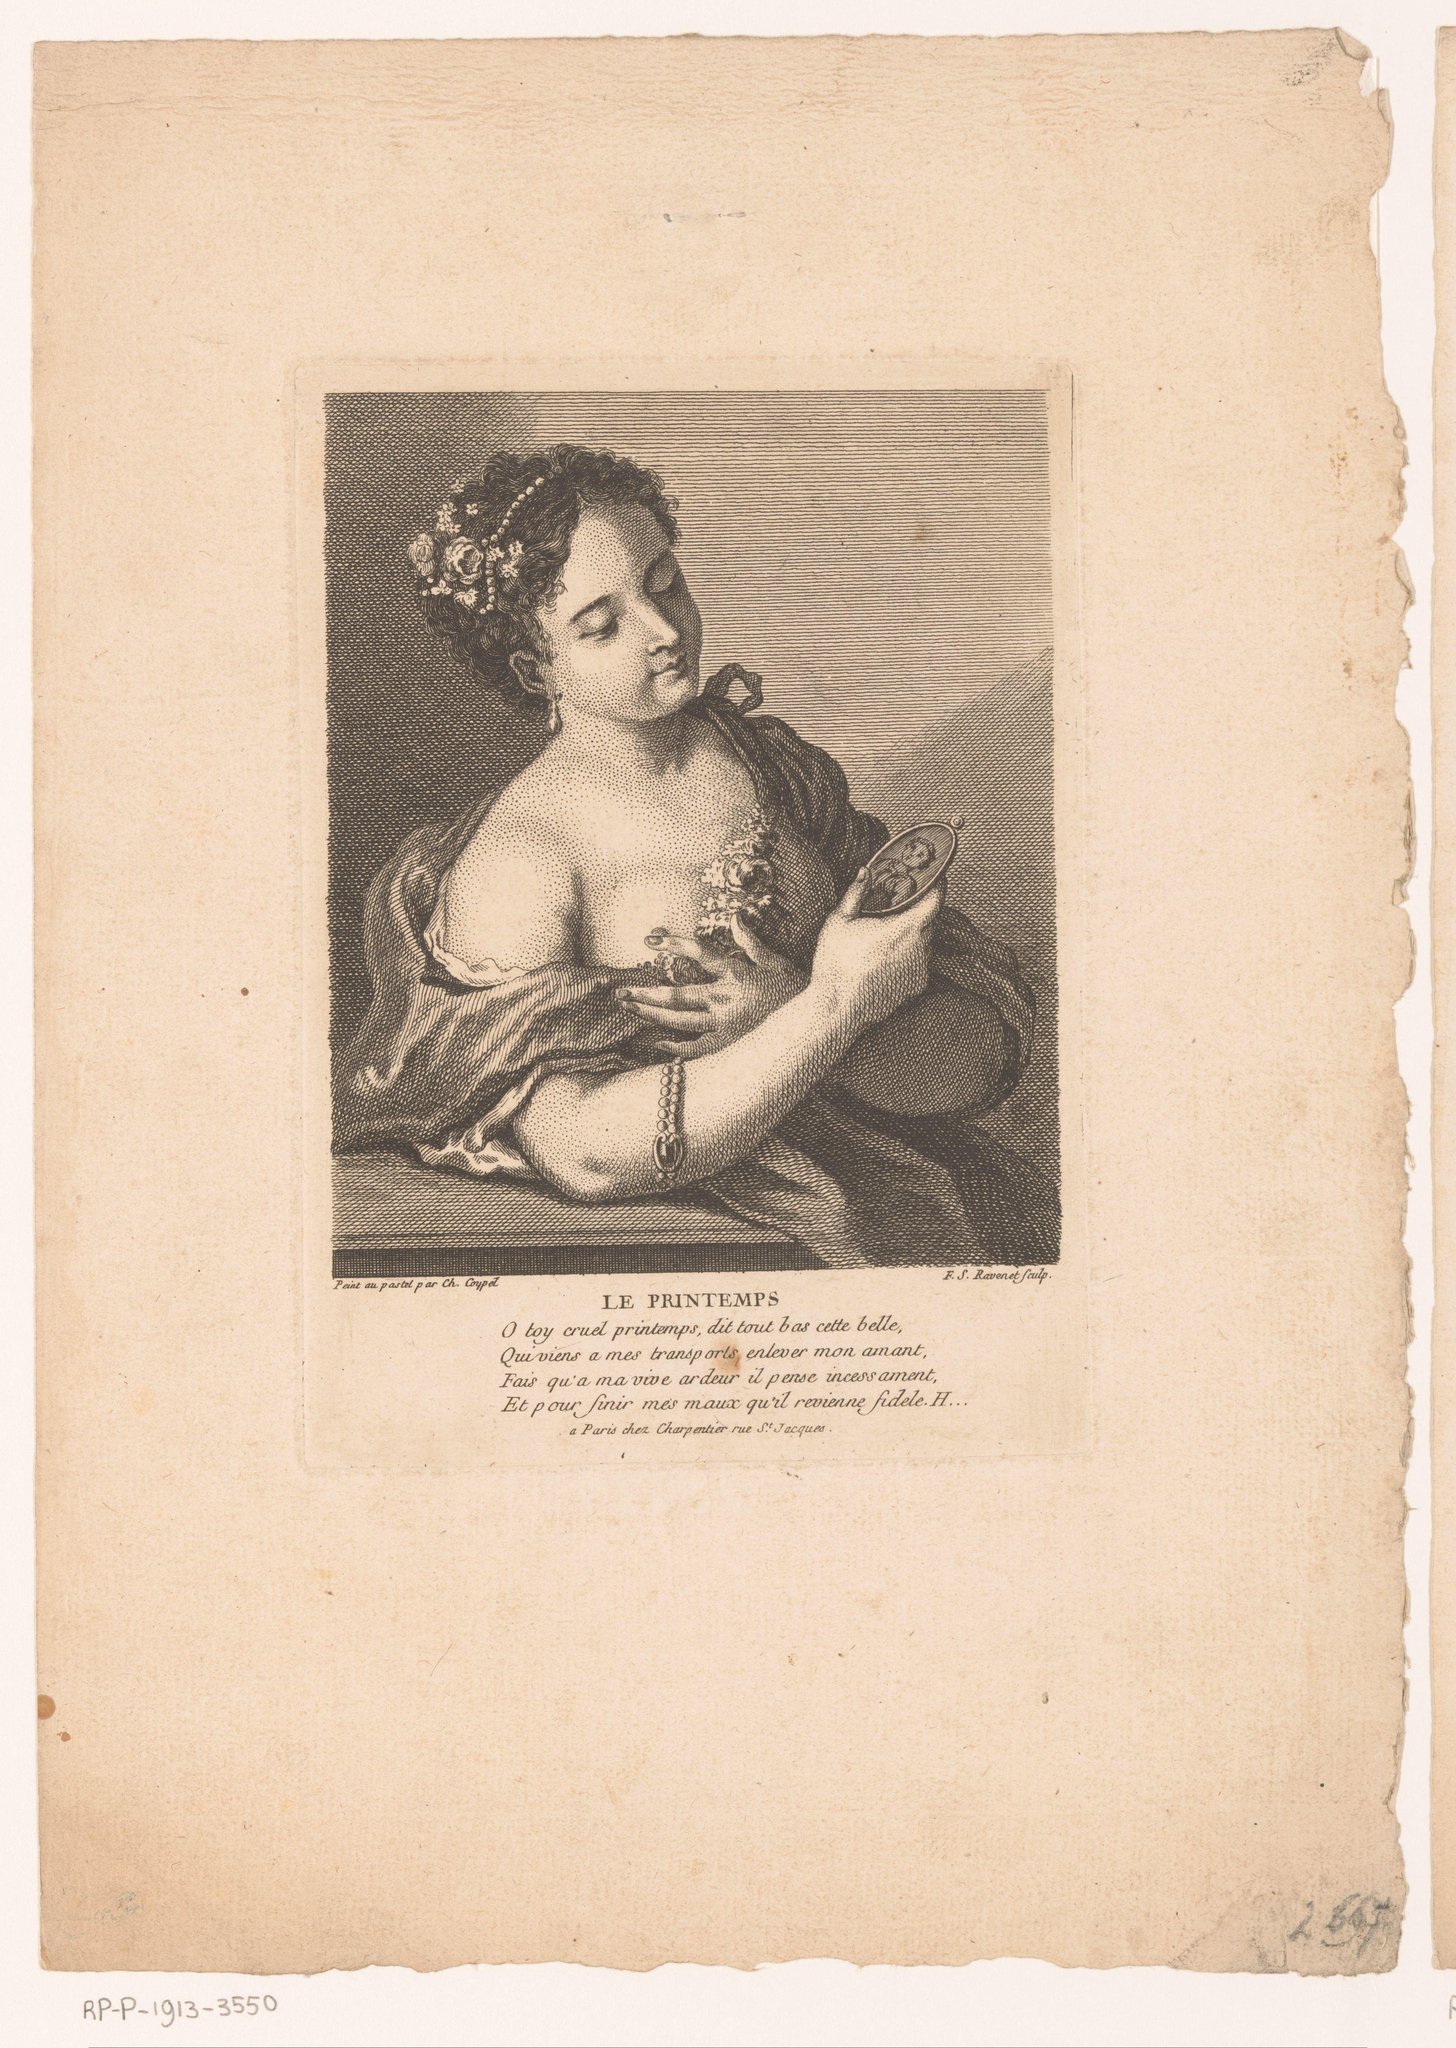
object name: print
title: Vier seizoenen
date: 1716-1774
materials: paper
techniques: engraving, etching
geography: paris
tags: seasons of the year represented by scenes showing human activities, usually in a landscape, spring, 'ver'; 'primavera' (ripa)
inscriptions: collector's mark: Lugt 2228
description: Vrouw kijkt naar een klein portret dat ze in haar hand houdt.